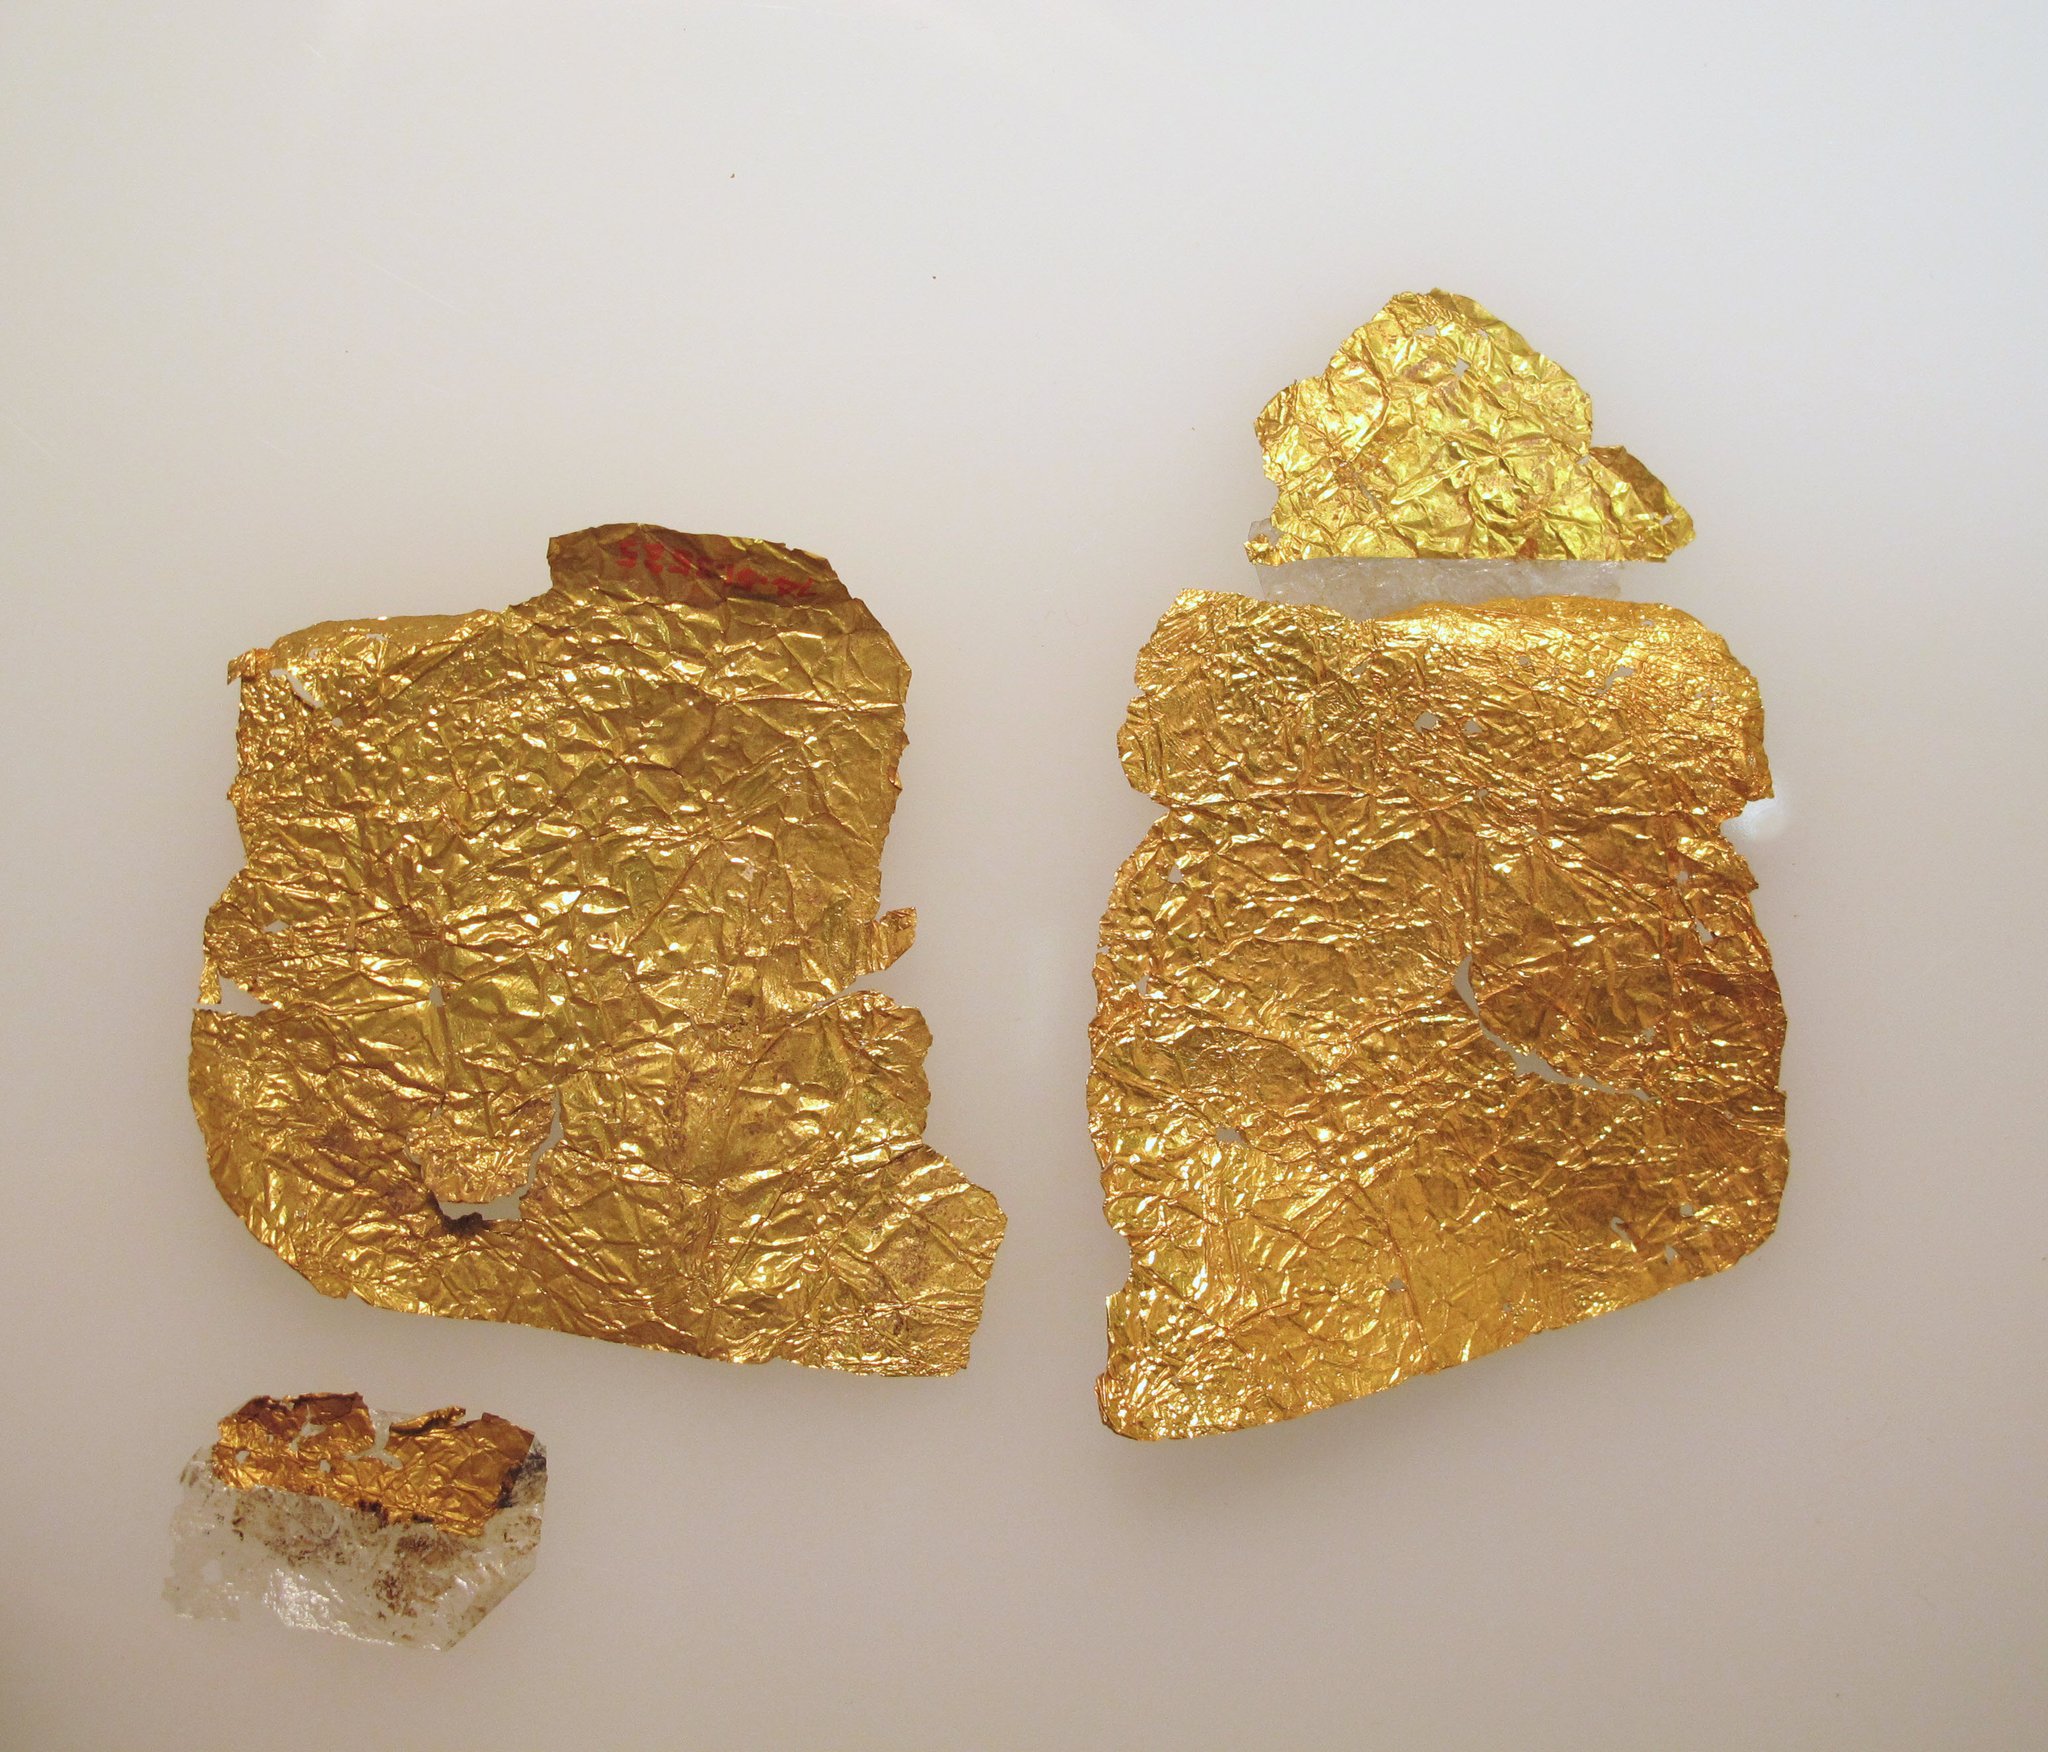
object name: frontlet of gold leaf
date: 7000 BCE-330 CE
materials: gold